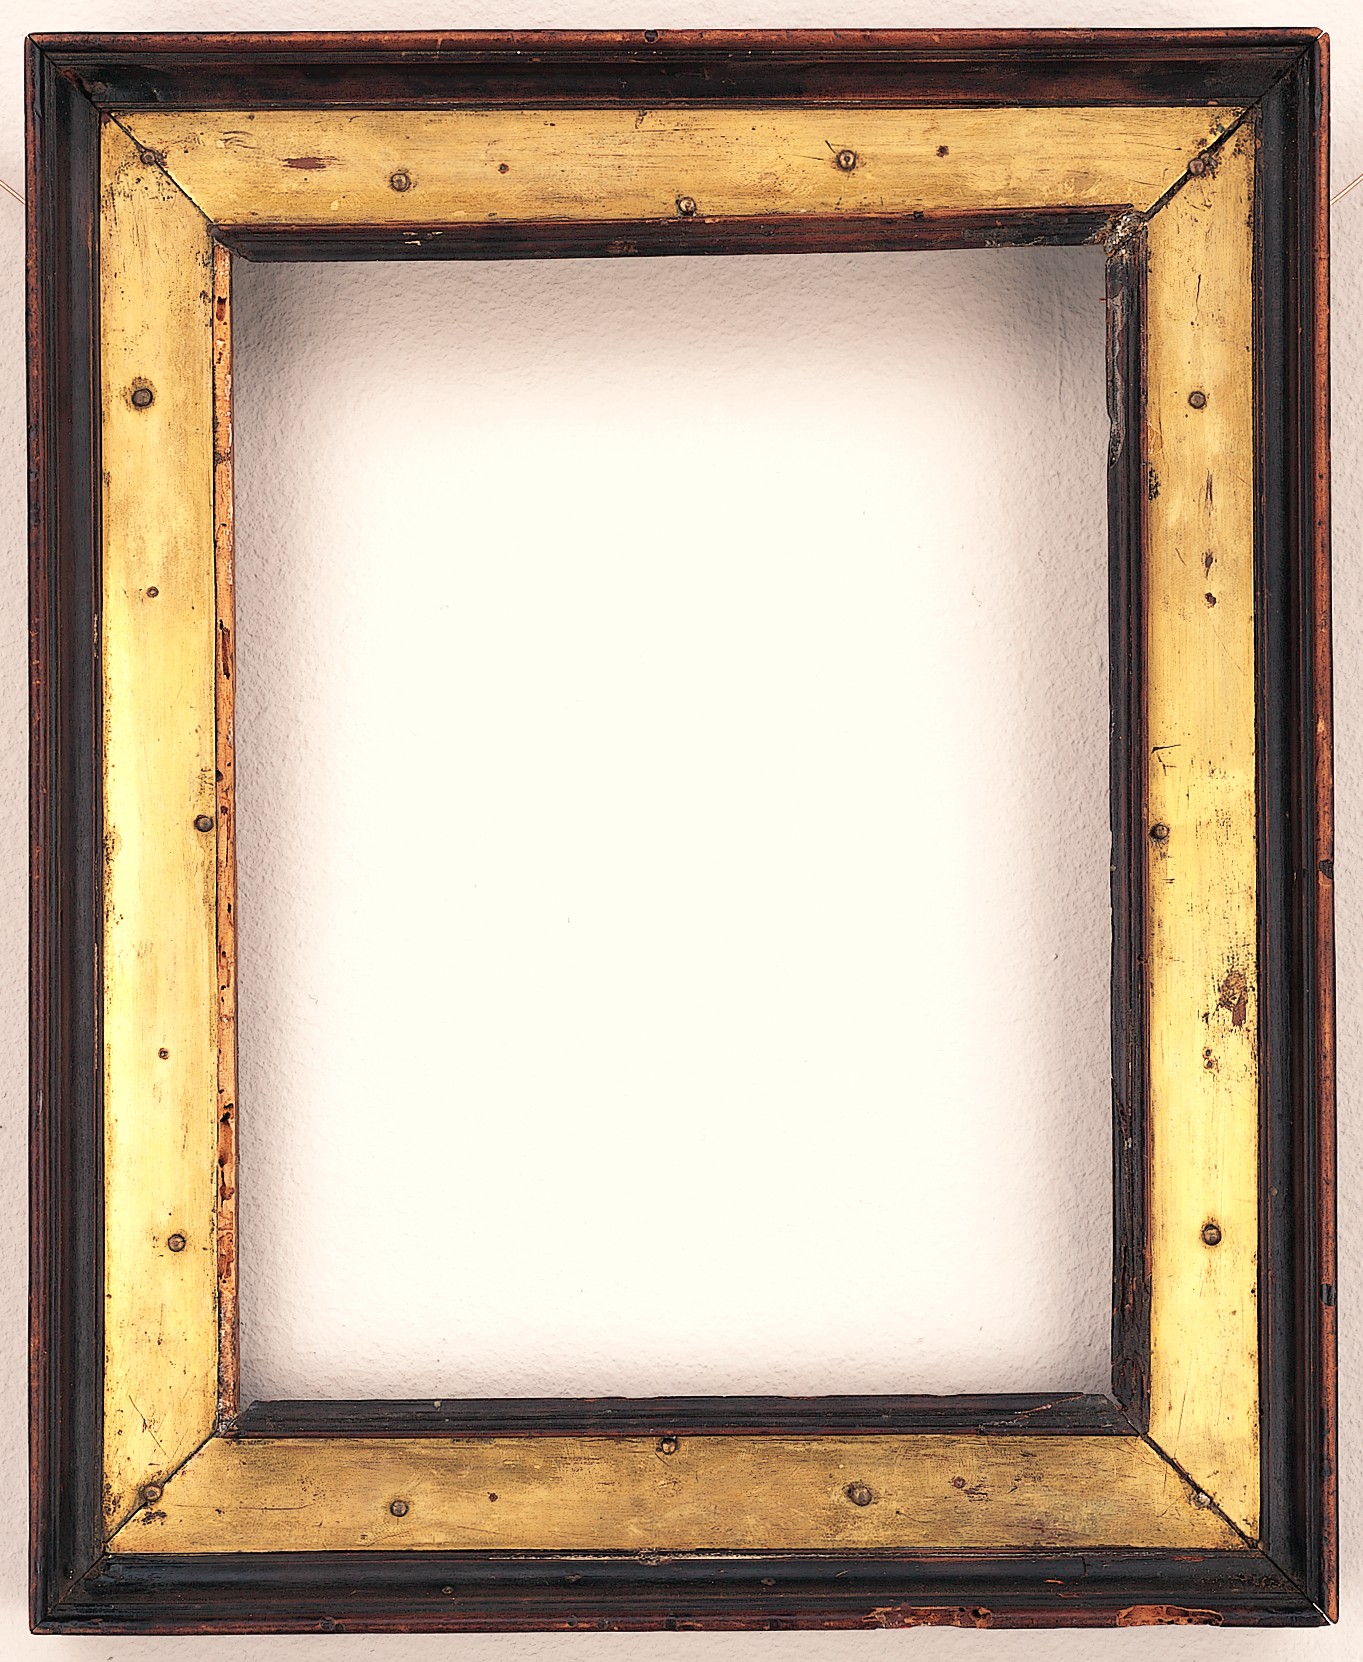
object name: frame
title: Cassetta frame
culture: italian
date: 1590-1610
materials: brass, wood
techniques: polish